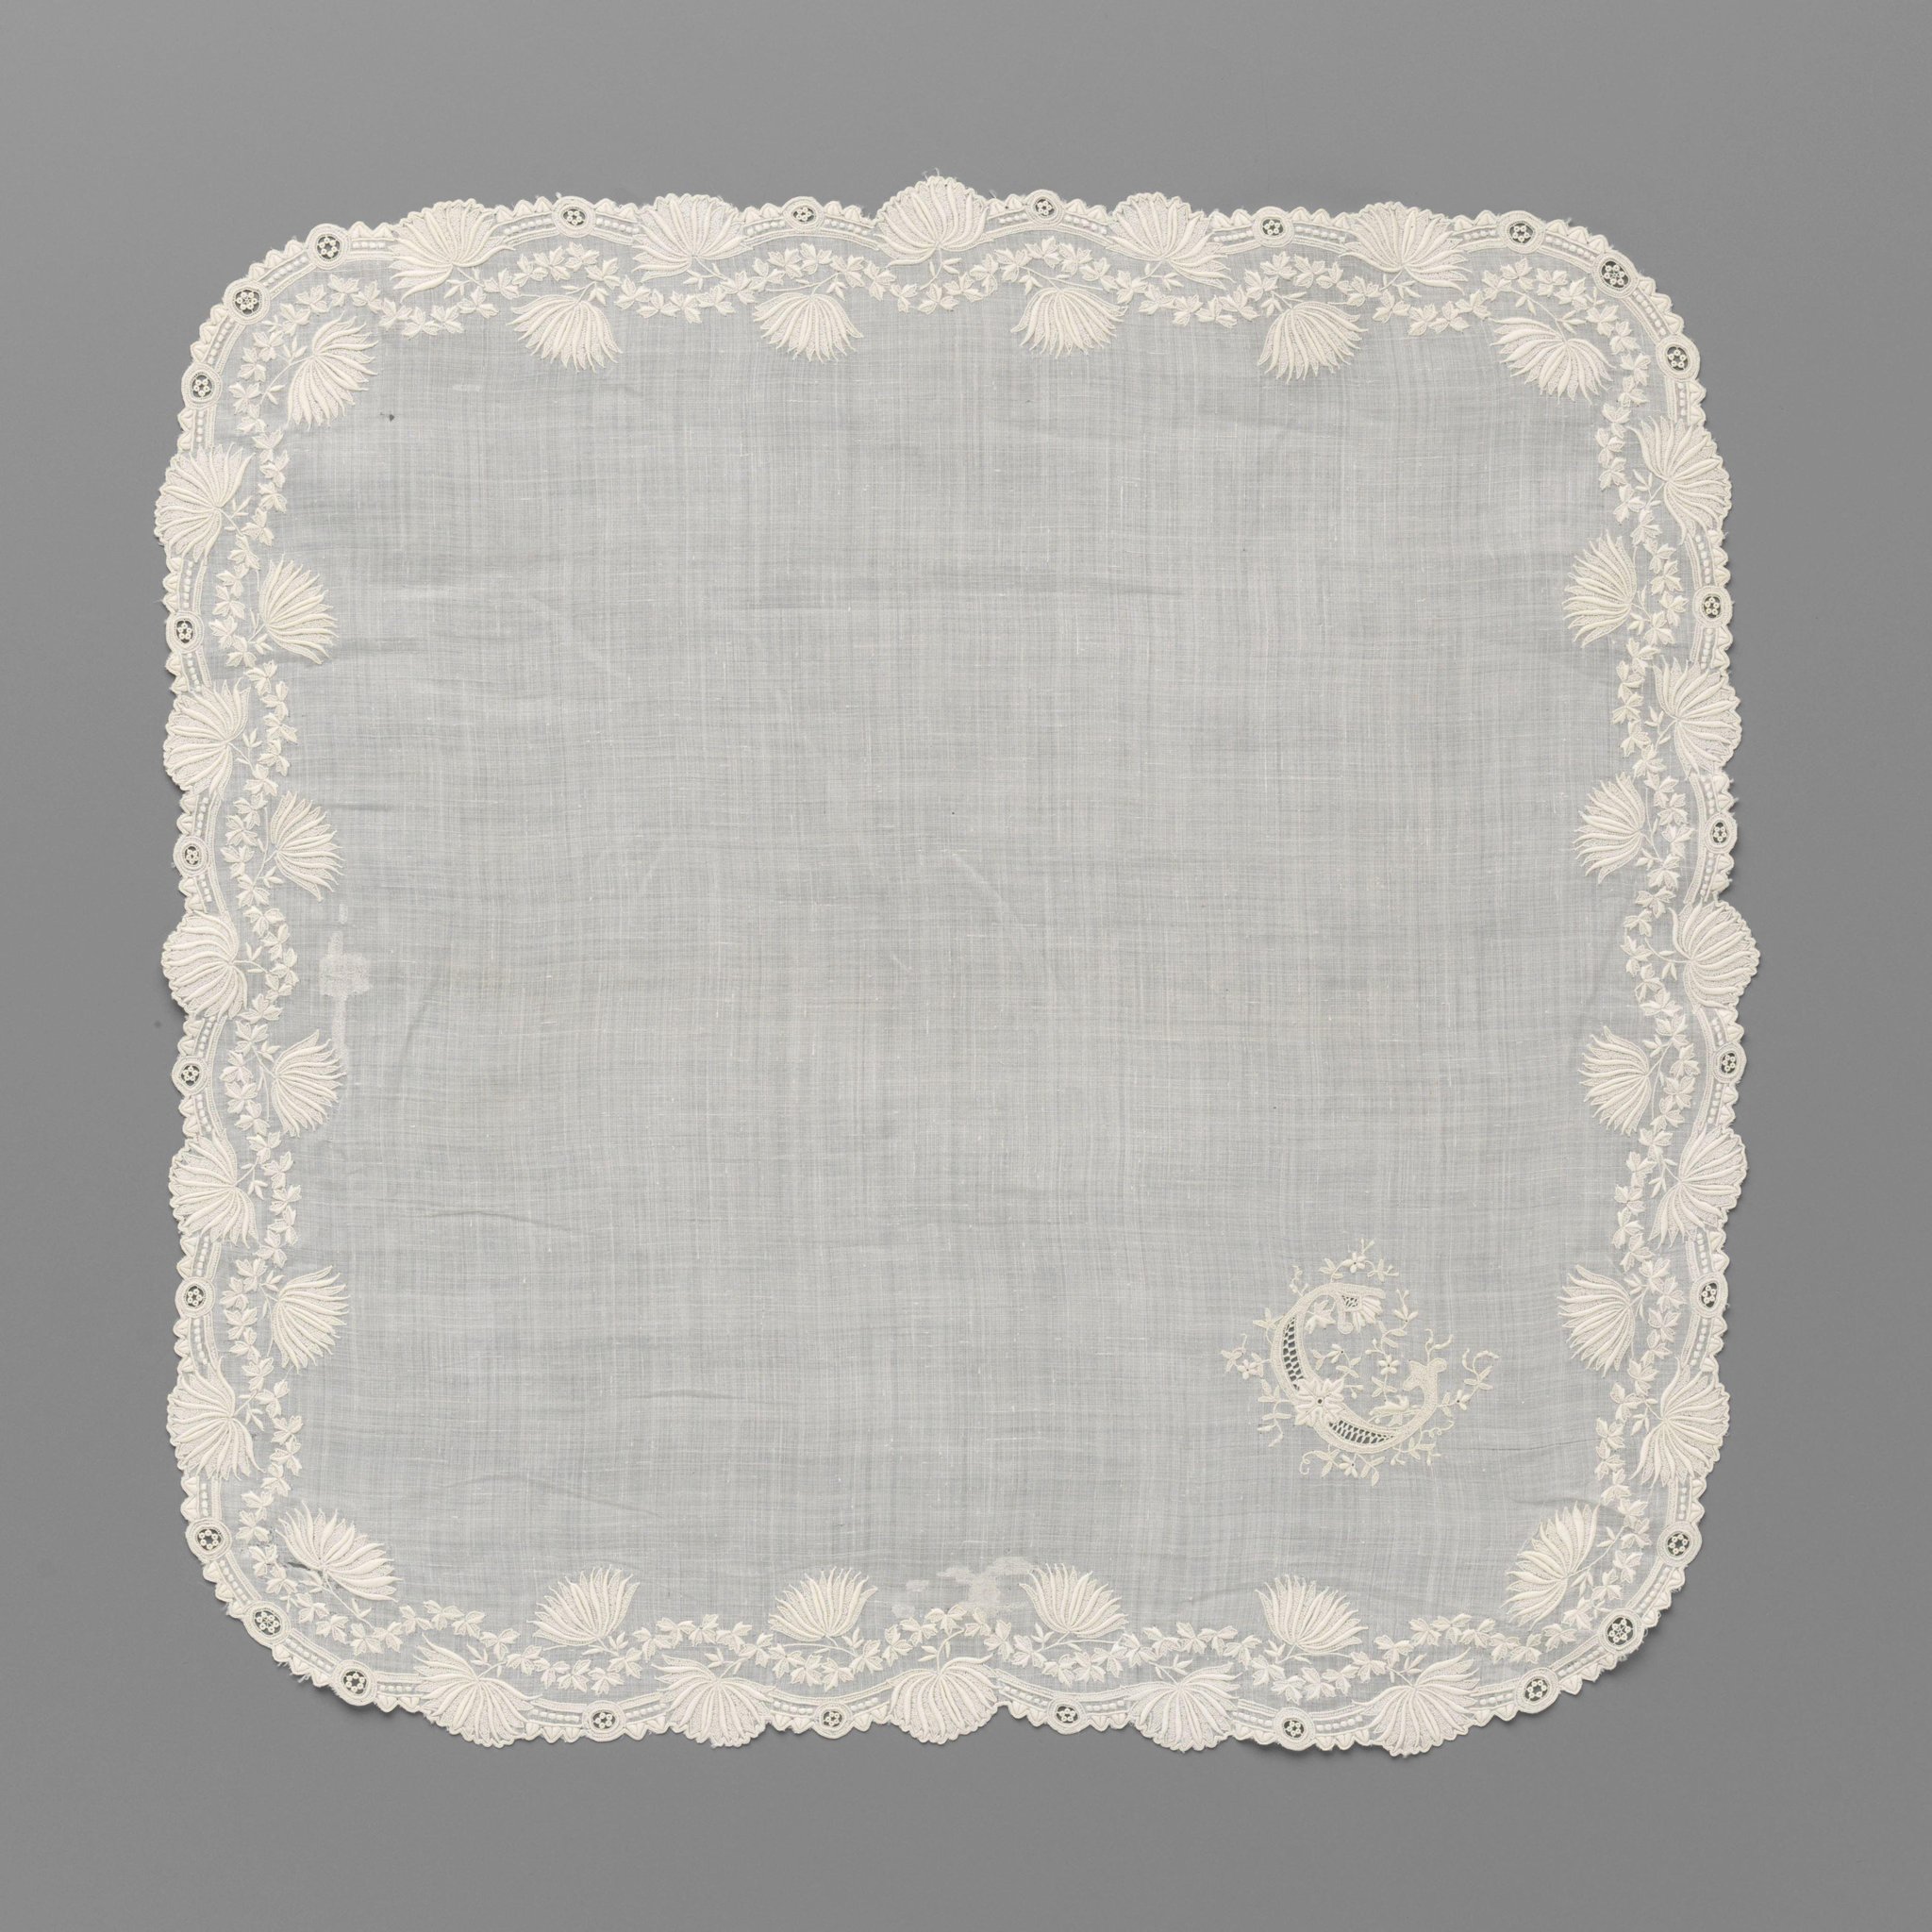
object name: handkerchief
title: Zakdoek van batist met plumetis borduurwerk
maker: Anonymous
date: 1850-1890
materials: linen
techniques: embroidered, weave, embroidery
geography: europe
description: Zakdoek van naturelkleurige batist met borduurwerk: witwerk met plumetis. Vierkant model met afgeronde hoeken en schulpenrand. Langs de randen van het batist loopt een sierband waarboven een golvende slinger van esdoornbladeren waaruit afwisselend naar boven en naar beneden grote waaiervormige bloemen ontspringen. In een hoek is de letter C geborduurd, versierd met bloemen en bladeren.